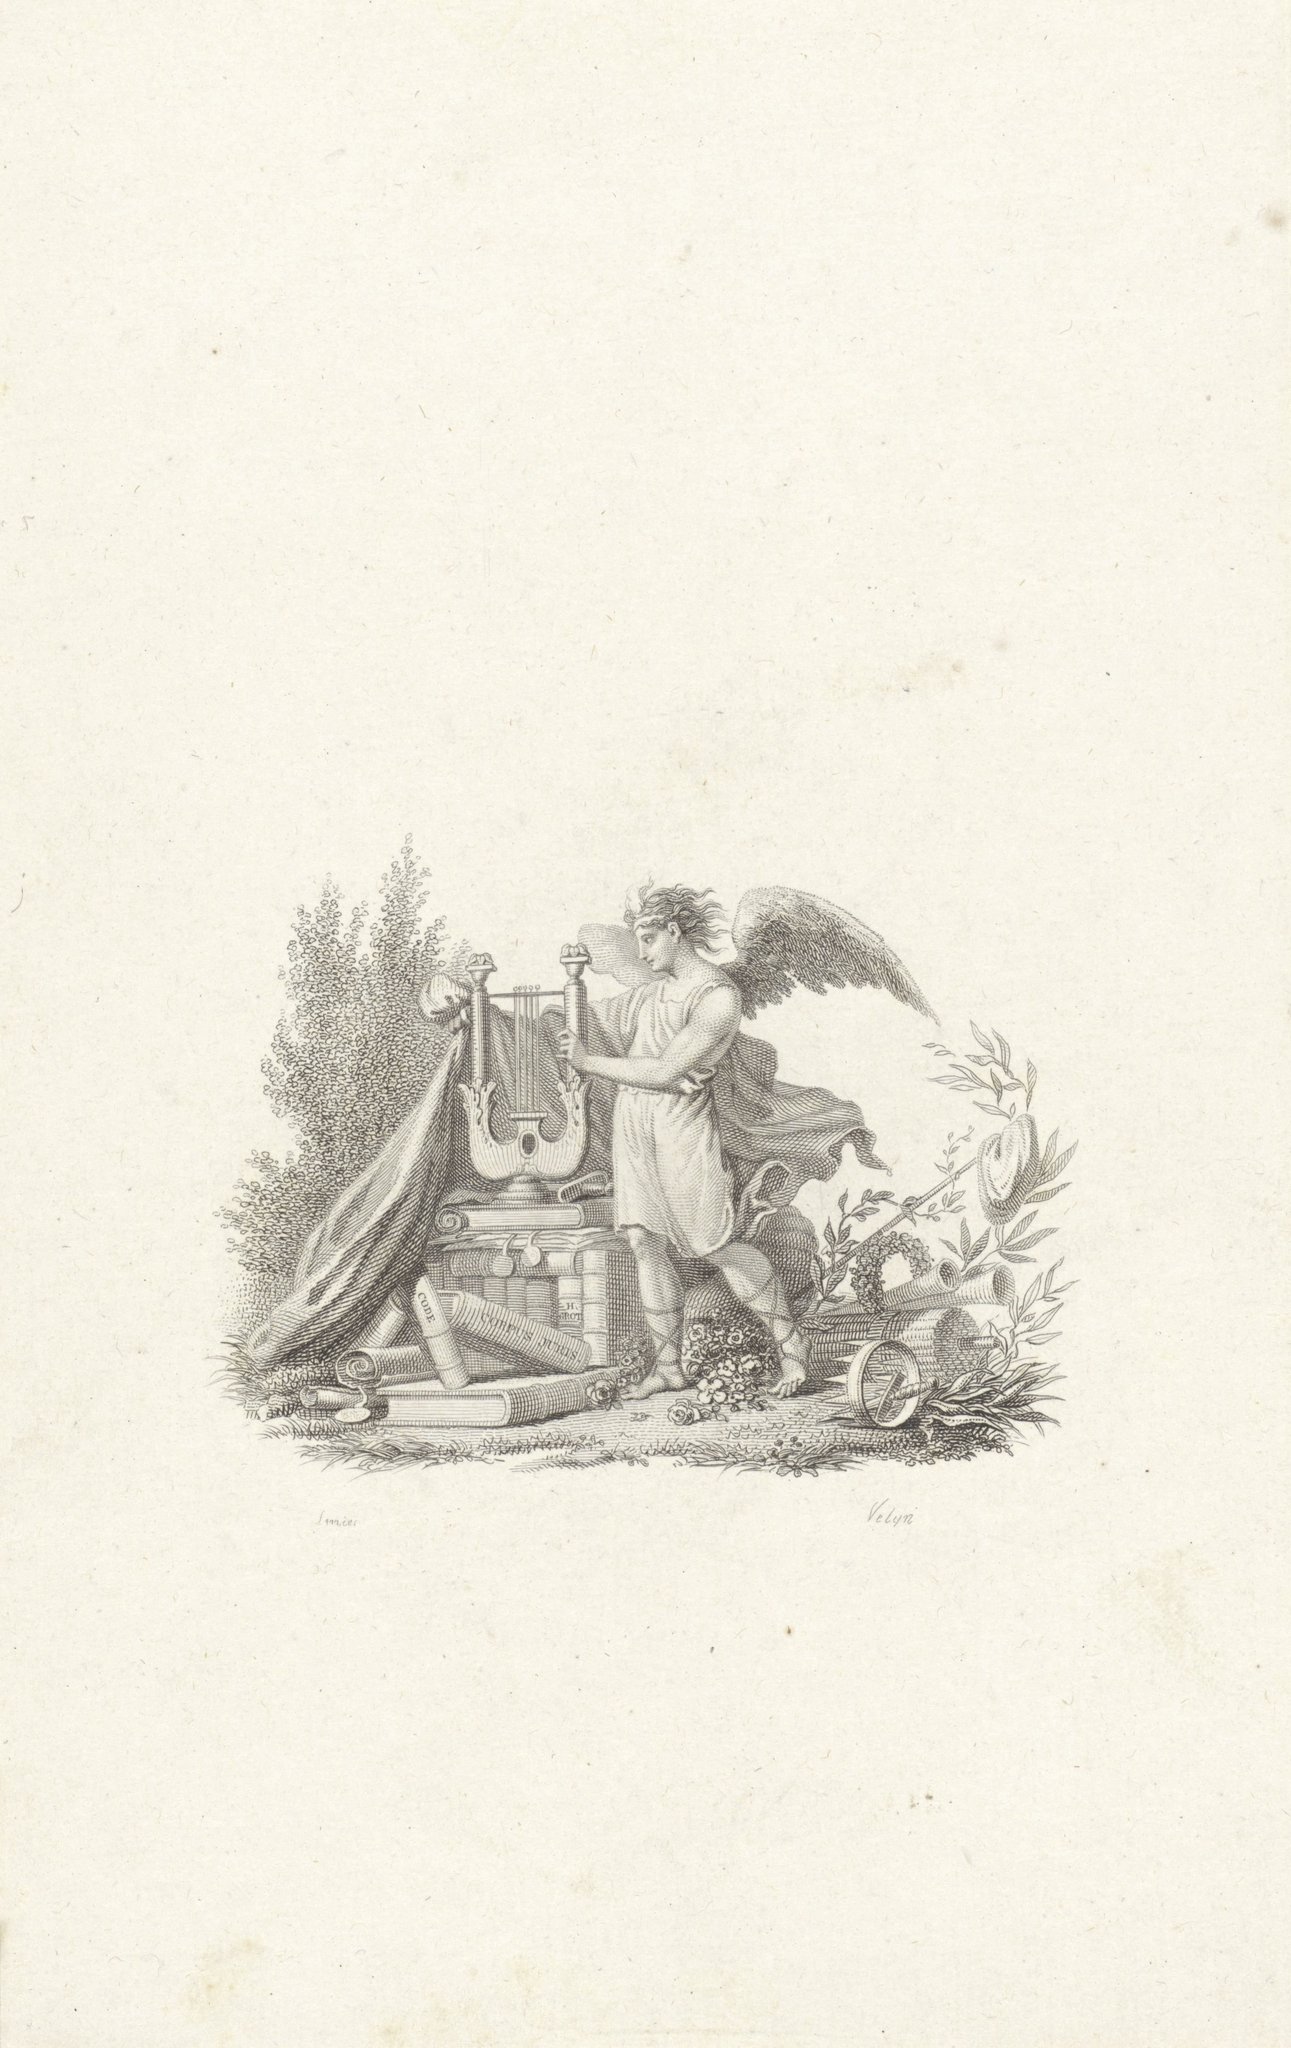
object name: print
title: Engel met een lier bij boeken in een landschap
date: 1797-1836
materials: paper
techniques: engraving, etching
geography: netherlands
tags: lyre, cithara, psaltery, book, angel(s) represented as youth(s) or adult(s)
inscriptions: collector's mark: Lugt 2228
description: Een engel met een lier bij een stapel boeken in een landschap. Naast de engel een fasces, een vrijheidsstaf met muts, twee bazuinen en een kroon met een kort zwaard.